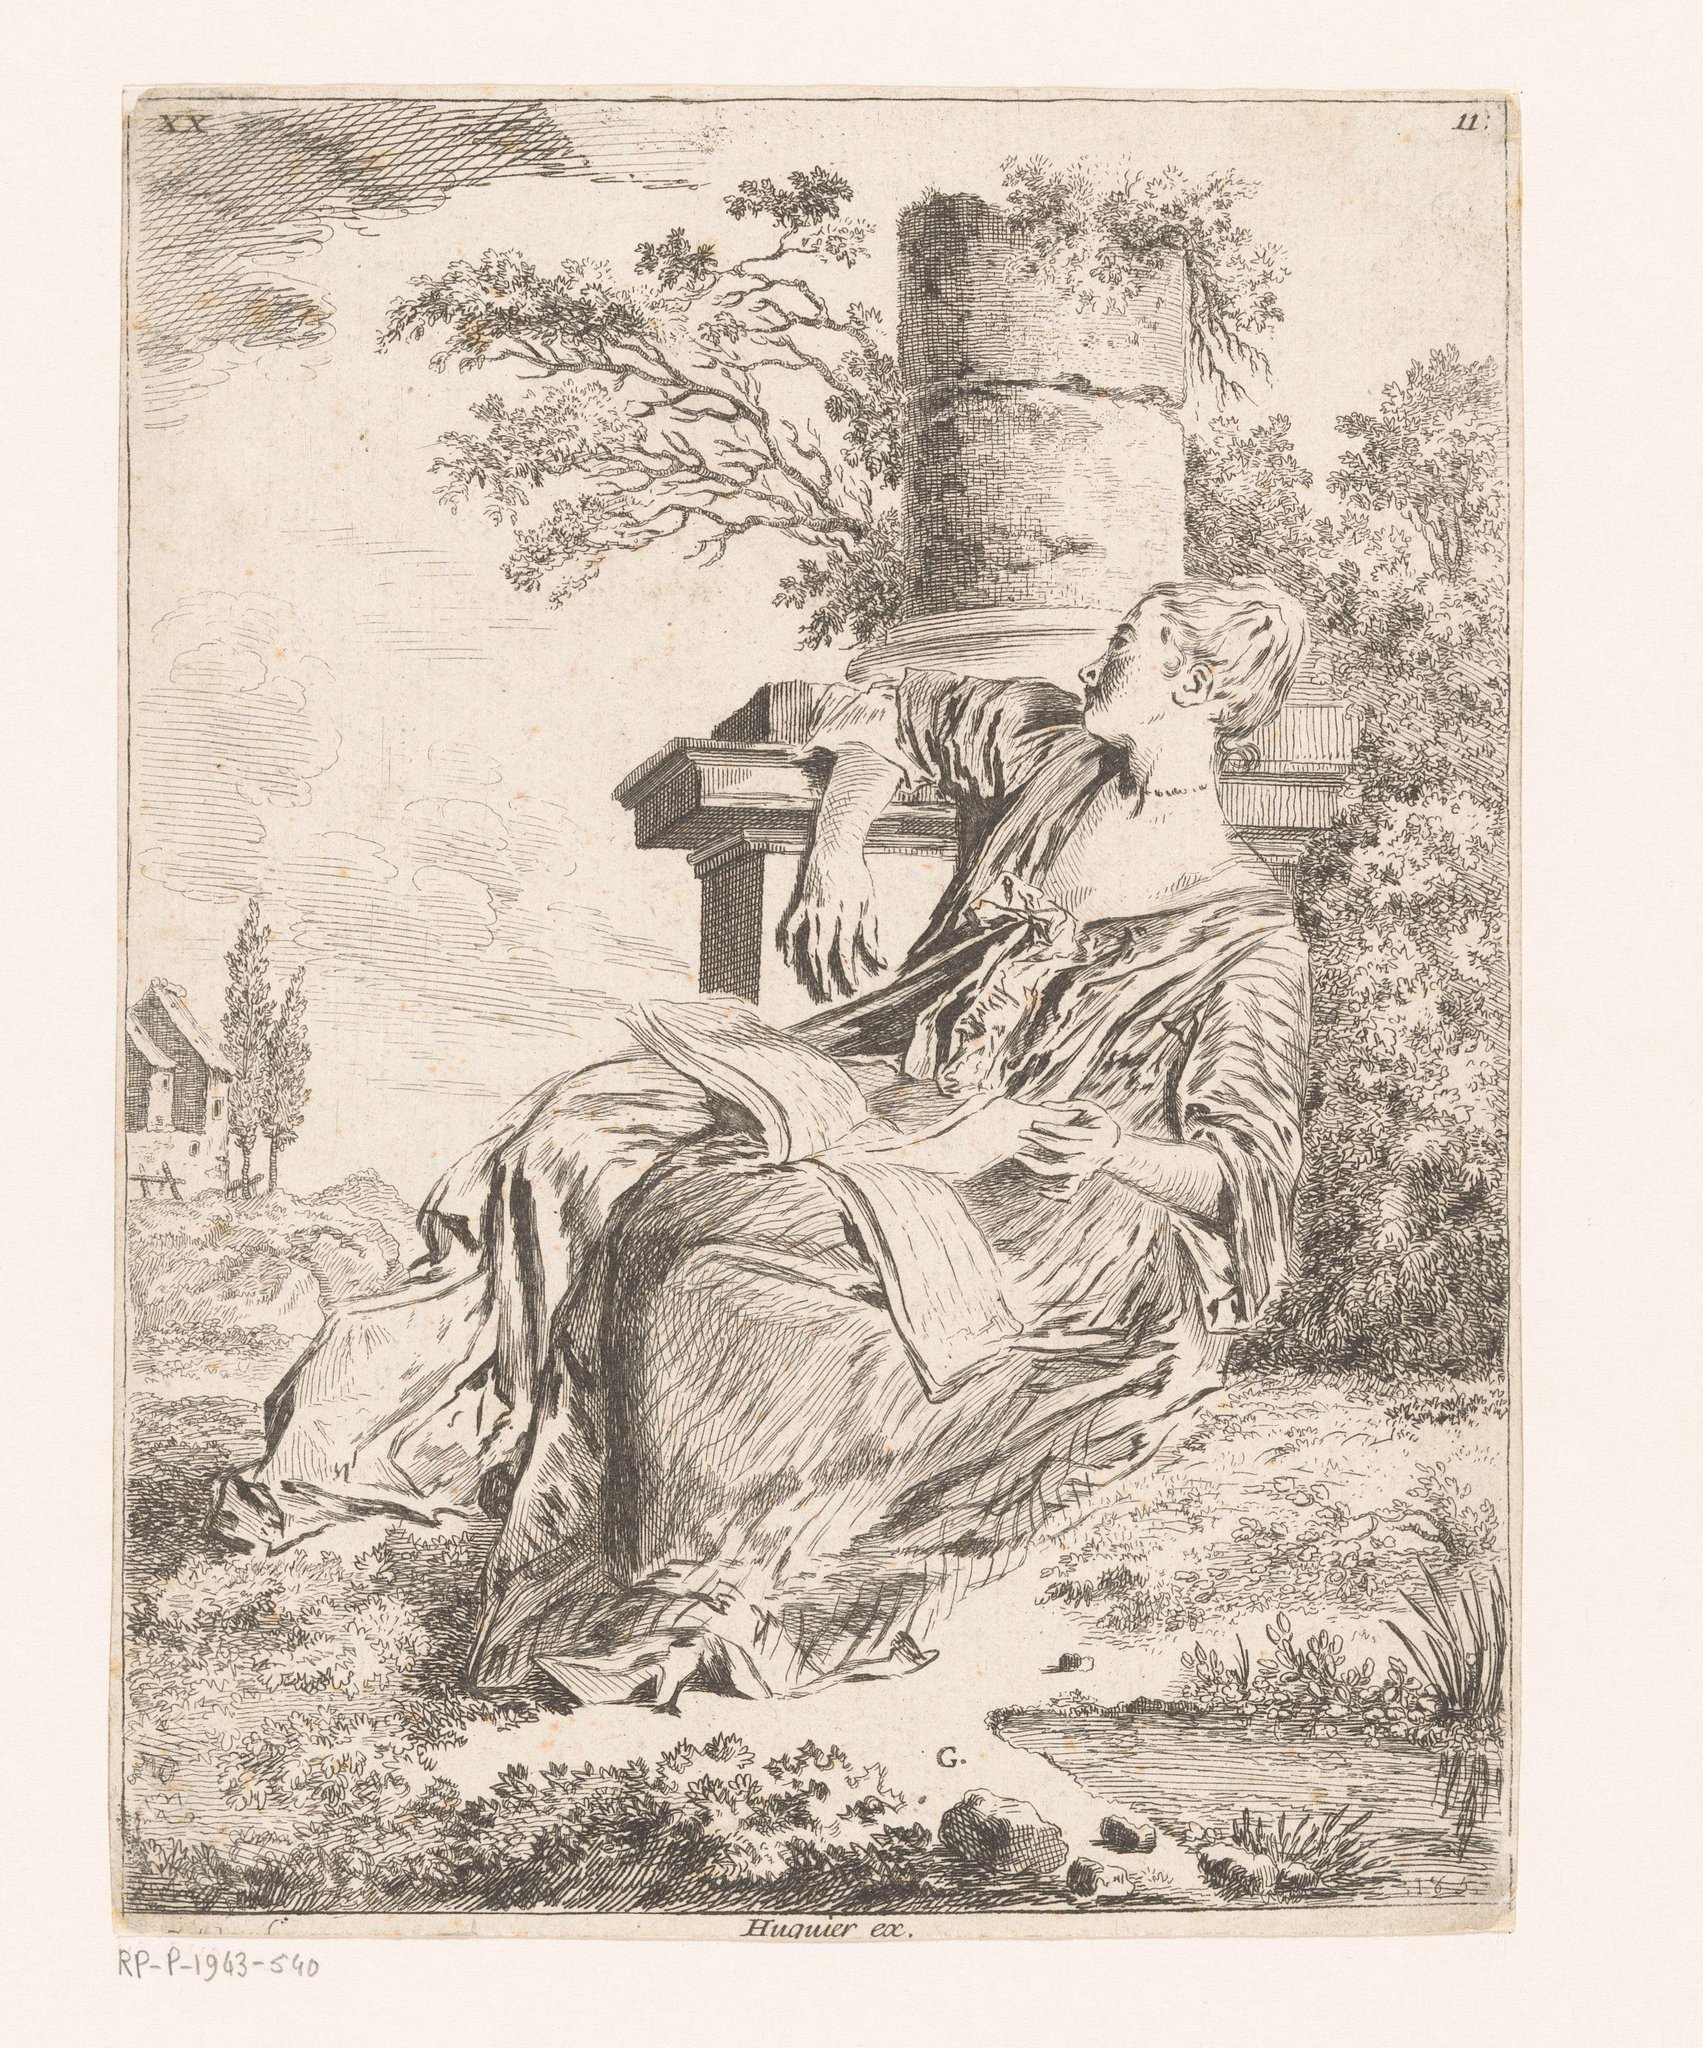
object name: print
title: Zittende vrouw met boek in een landschap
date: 1713-1770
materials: paper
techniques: etching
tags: adolescent, young woman, maiden, reading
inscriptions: collector's mark: Lugt 2228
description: Genummerd linksboven: XX. Genummerd rechtsboven: 11. Genummerd rechtsonder: 165.